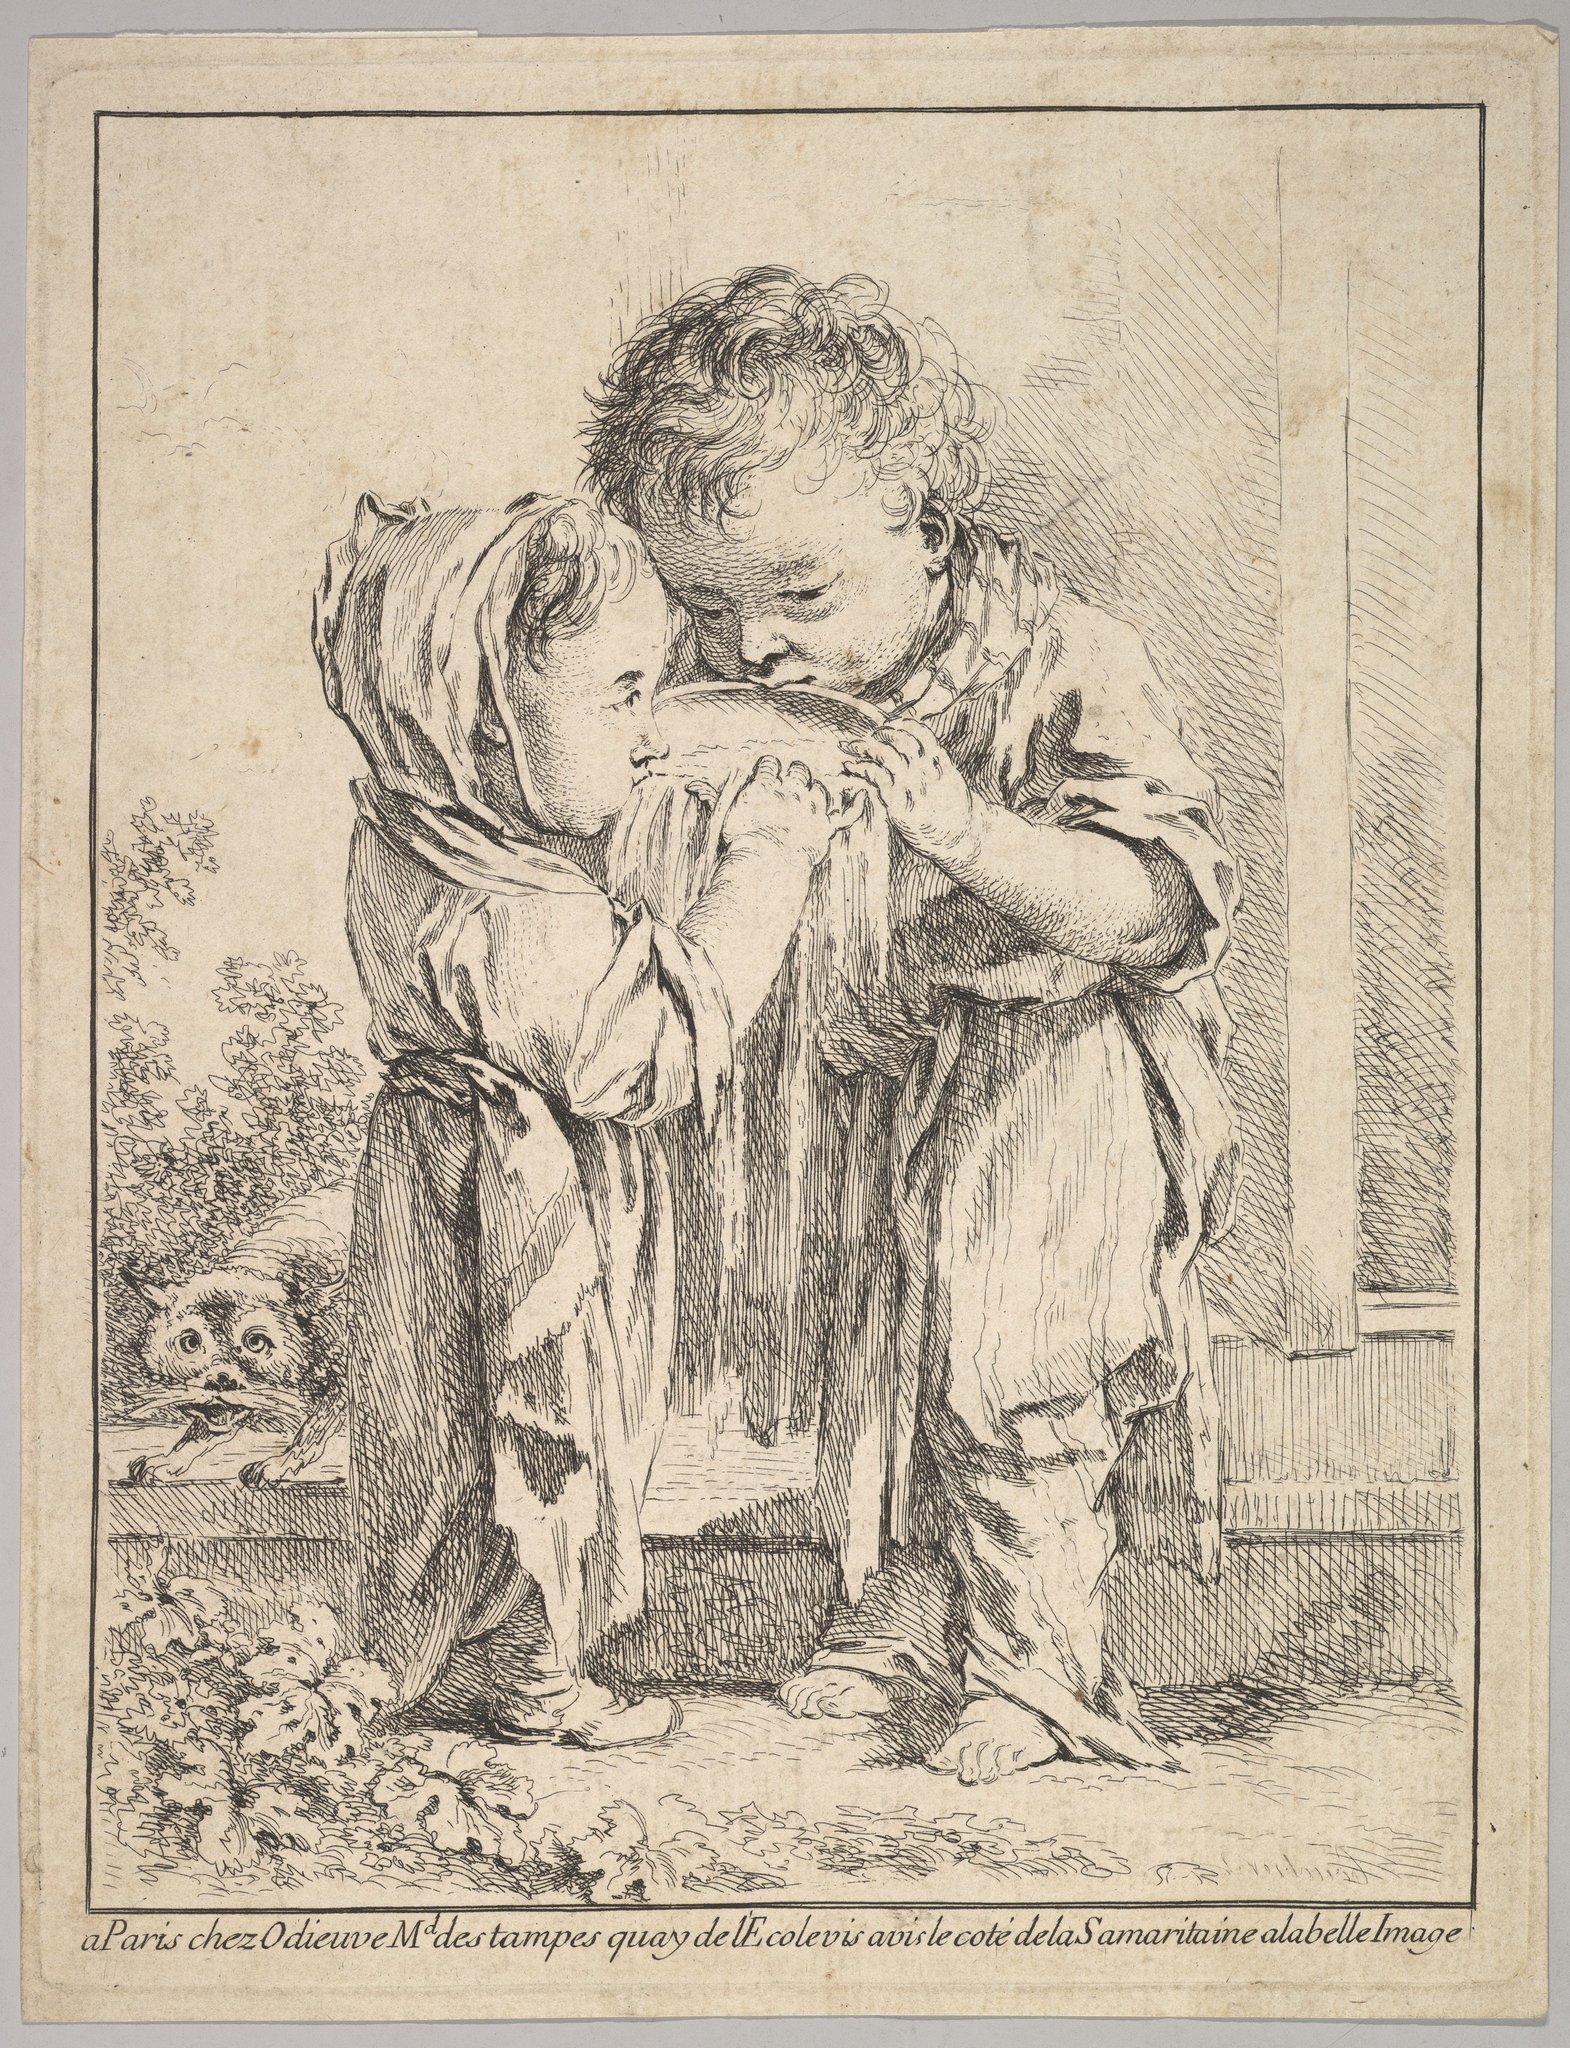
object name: print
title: Les Petits Buveurs de Lait (The Little Milk Drinkers)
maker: Anonymous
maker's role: artist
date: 1701-1800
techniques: etching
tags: children,dogs,drinking